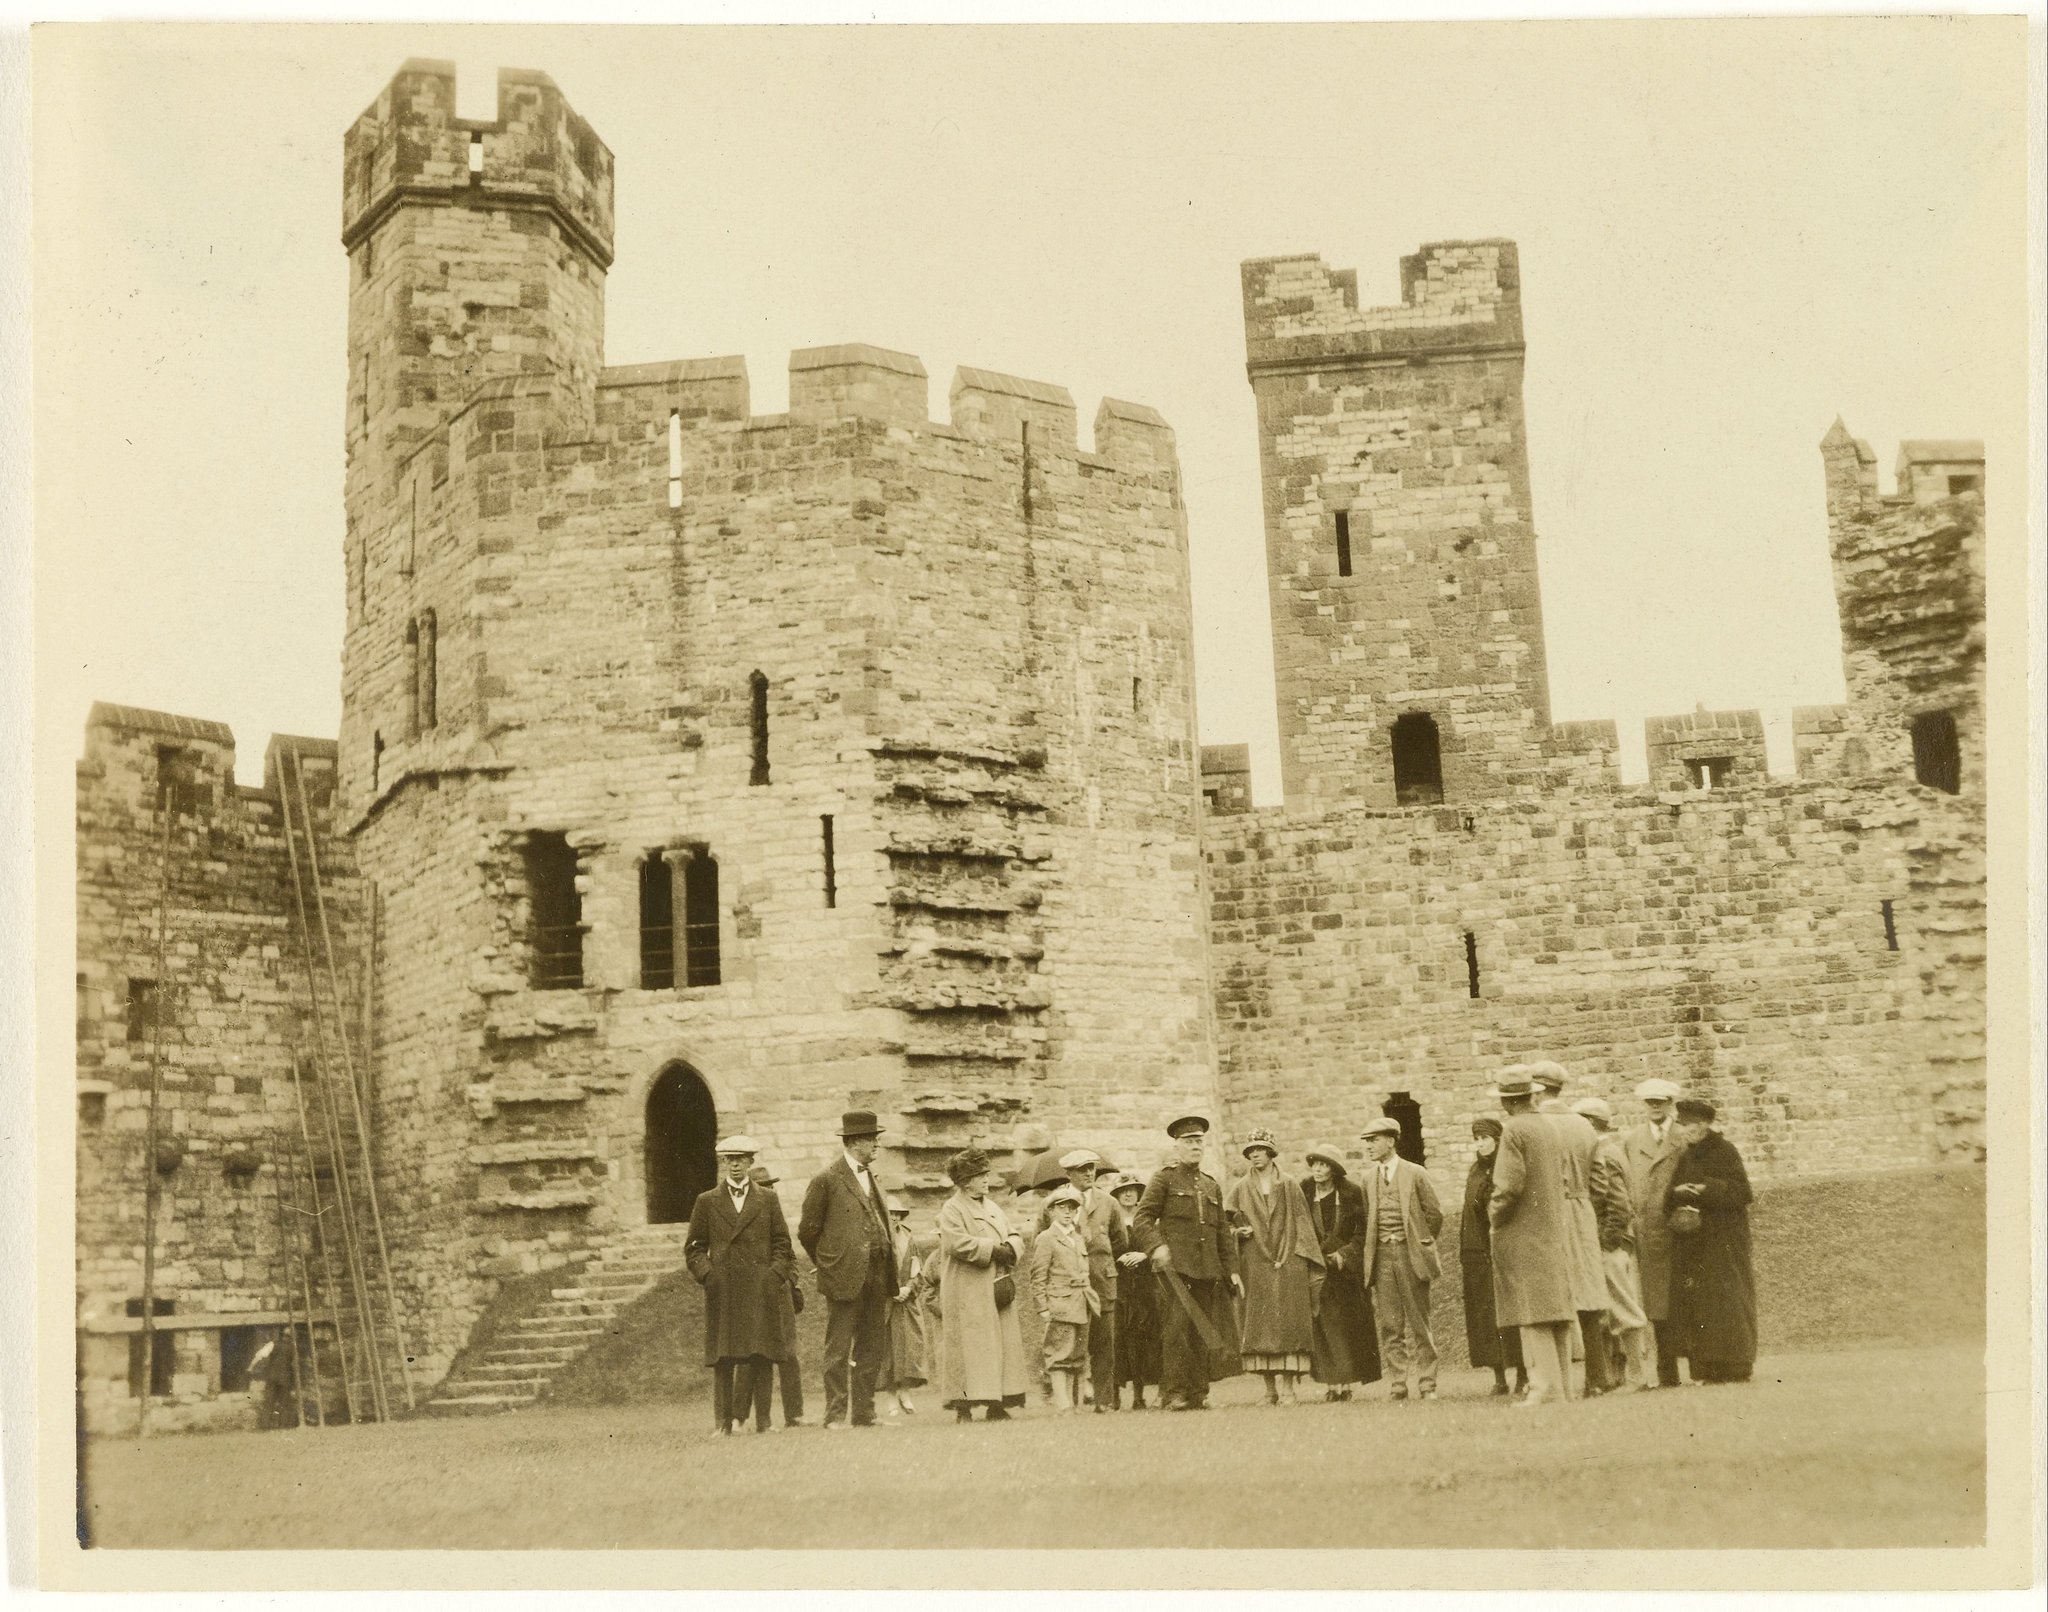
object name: photograph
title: Groep Amerikaanse toeristen bij een kasteel, Engeland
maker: Anonymous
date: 1921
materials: paper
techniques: gelatin silver print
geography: north and central america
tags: tourism, castle